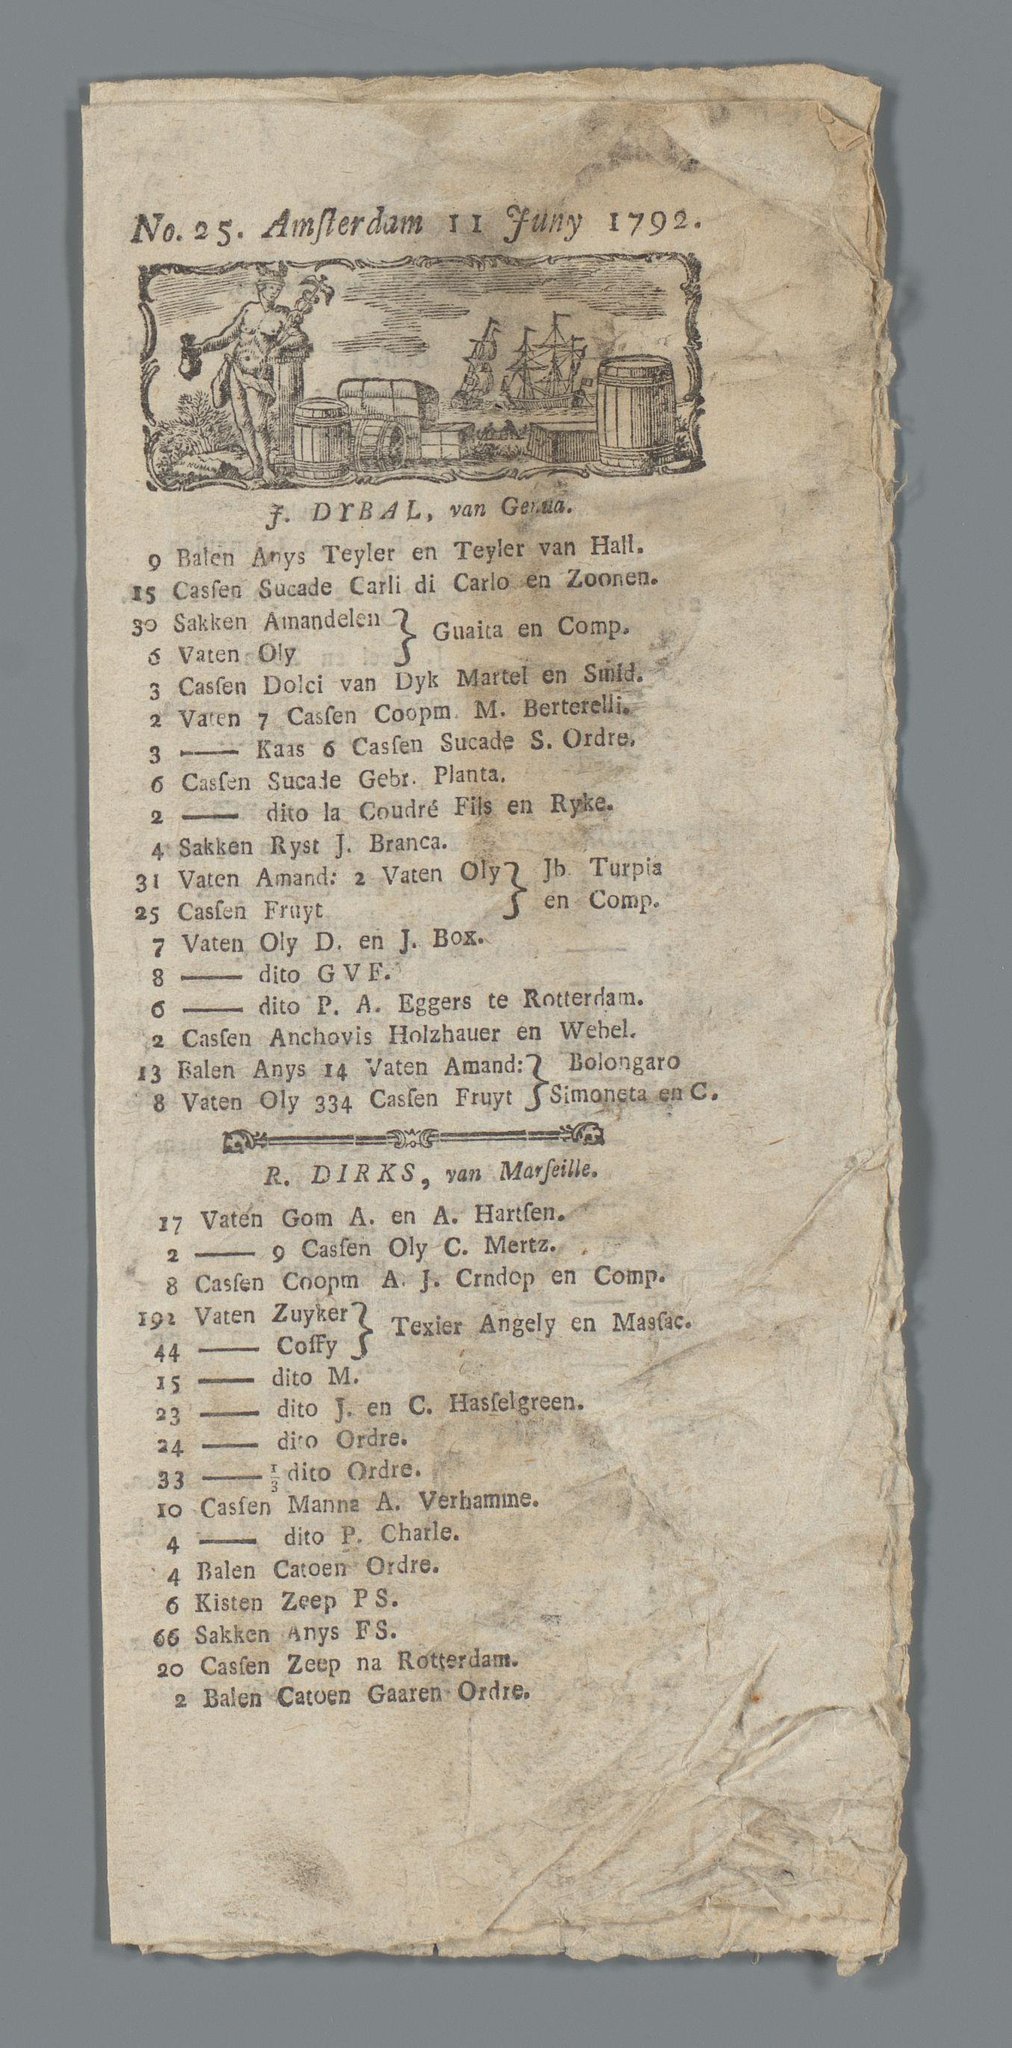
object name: document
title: Scheeps- of beurstijding Nr. 25 Amsterdam 11 Juni 1790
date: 1790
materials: paper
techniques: letterpress printing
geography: amsterdam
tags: specific aspects, allegorical aspects of mercury; mercury as patron, merchant shipping, shipping trade, merchant, salesman, amsterdam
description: Scheeps- of beurstijdingen met lijst van de kapiteins met de plaats waar ze vandaan kwamen en wat ze hebben aangevoerd. In vieren gevouwen blad met tekst, genummerd p. 125-132. Voorzijde bovenaan een vignet met Mercurius op de kade tussen koopwaar, schepen op de achtergrond.